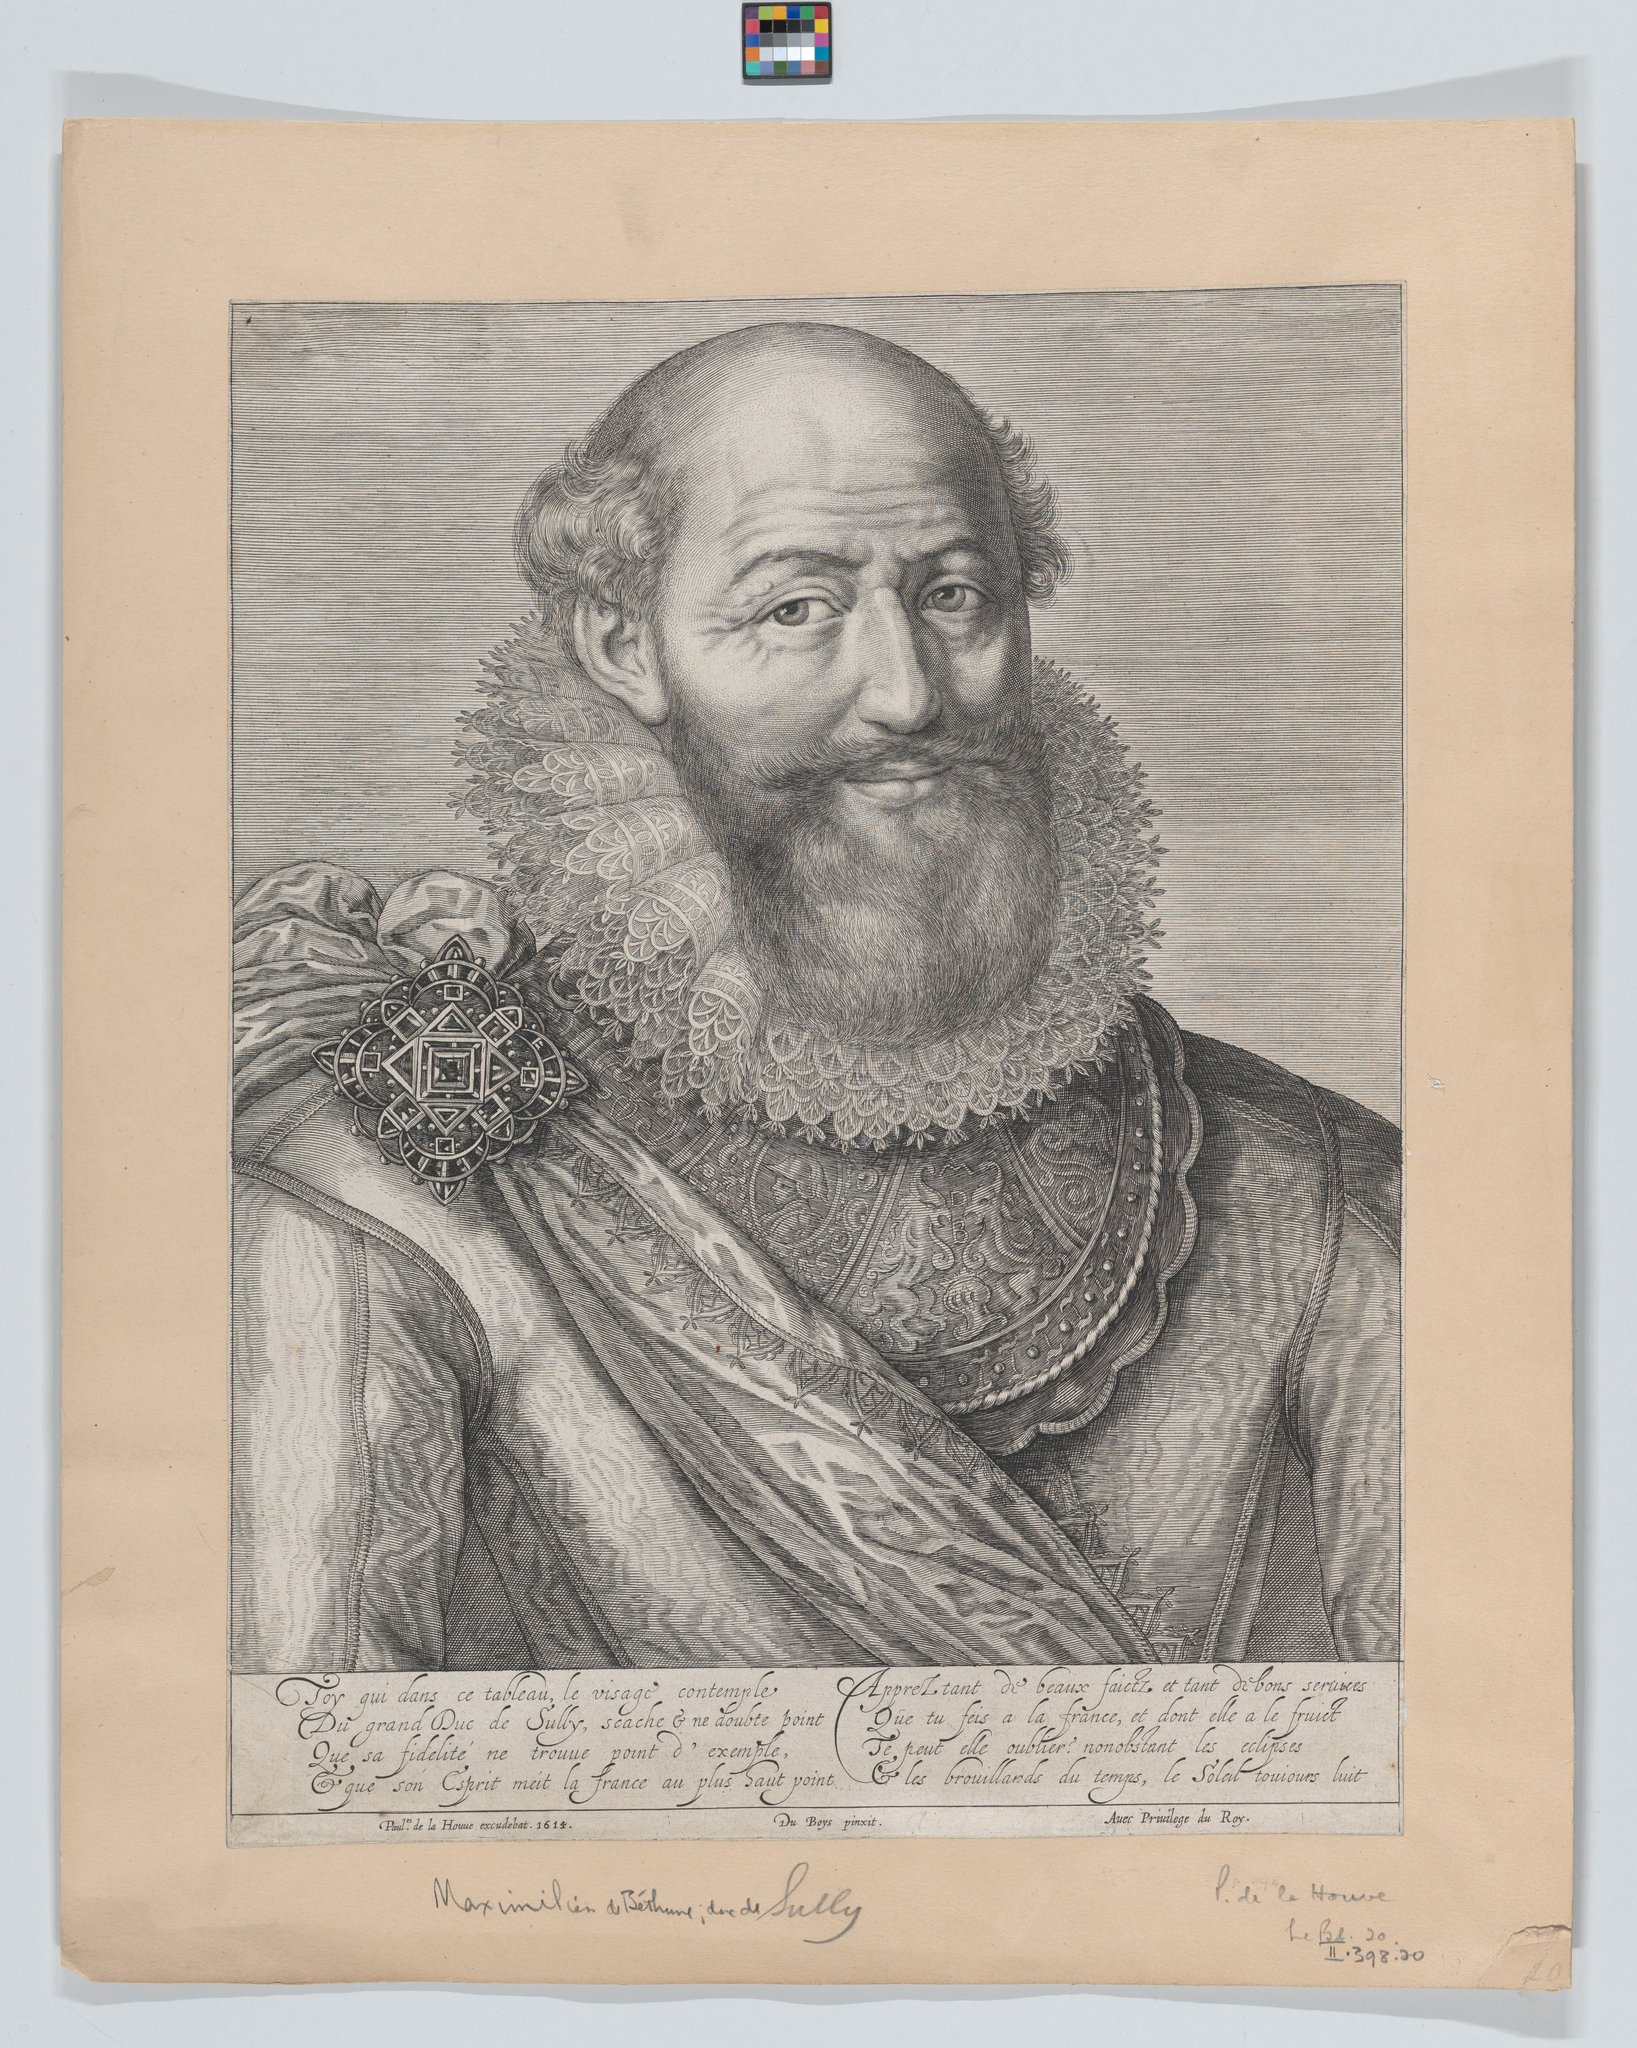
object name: print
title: Portrait of Maximilien de Béthune, Duc de Sully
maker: jacob matham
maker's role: artist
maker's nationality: netherlandish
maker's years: 1571-1631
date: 1612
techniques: engraving, etching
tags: men,portraits